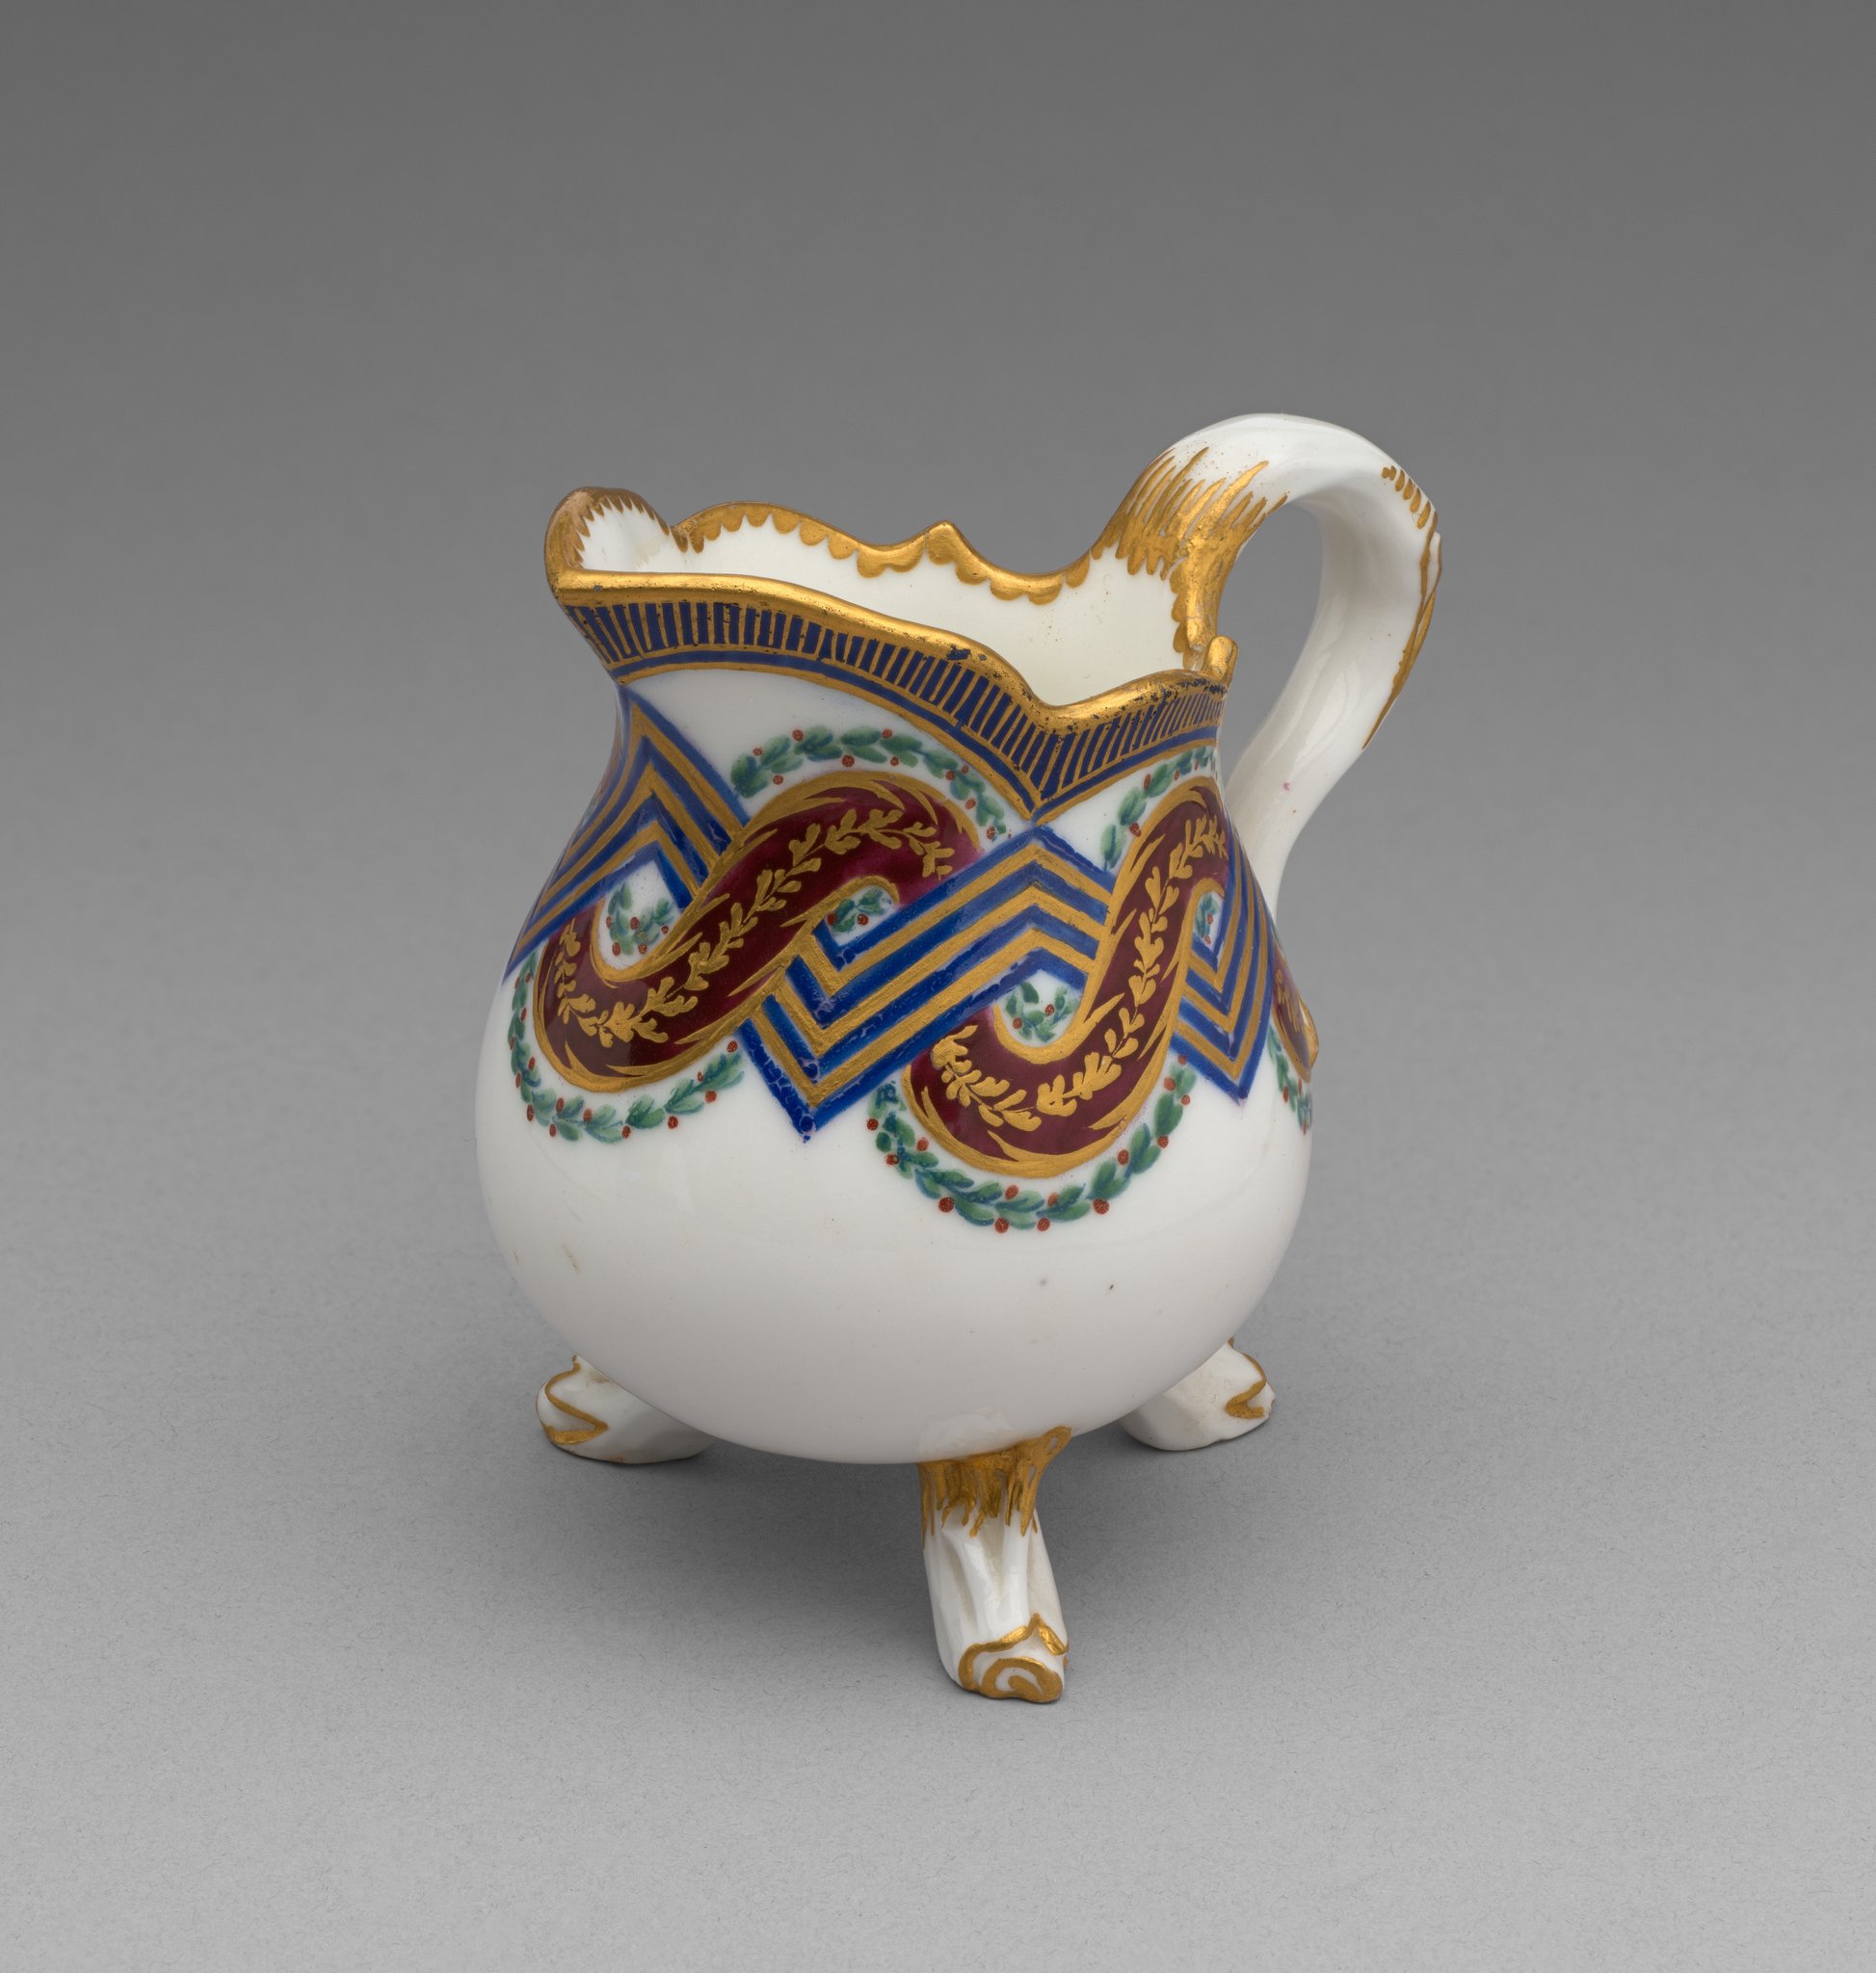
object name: teapot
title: Teapot (théière ‘Calabre,’ grandeur E) (part of a déjeuner service)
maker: sèvres manufactory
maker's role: maker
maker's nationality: french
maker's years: 1740-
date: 1763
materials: soft paste porcelain